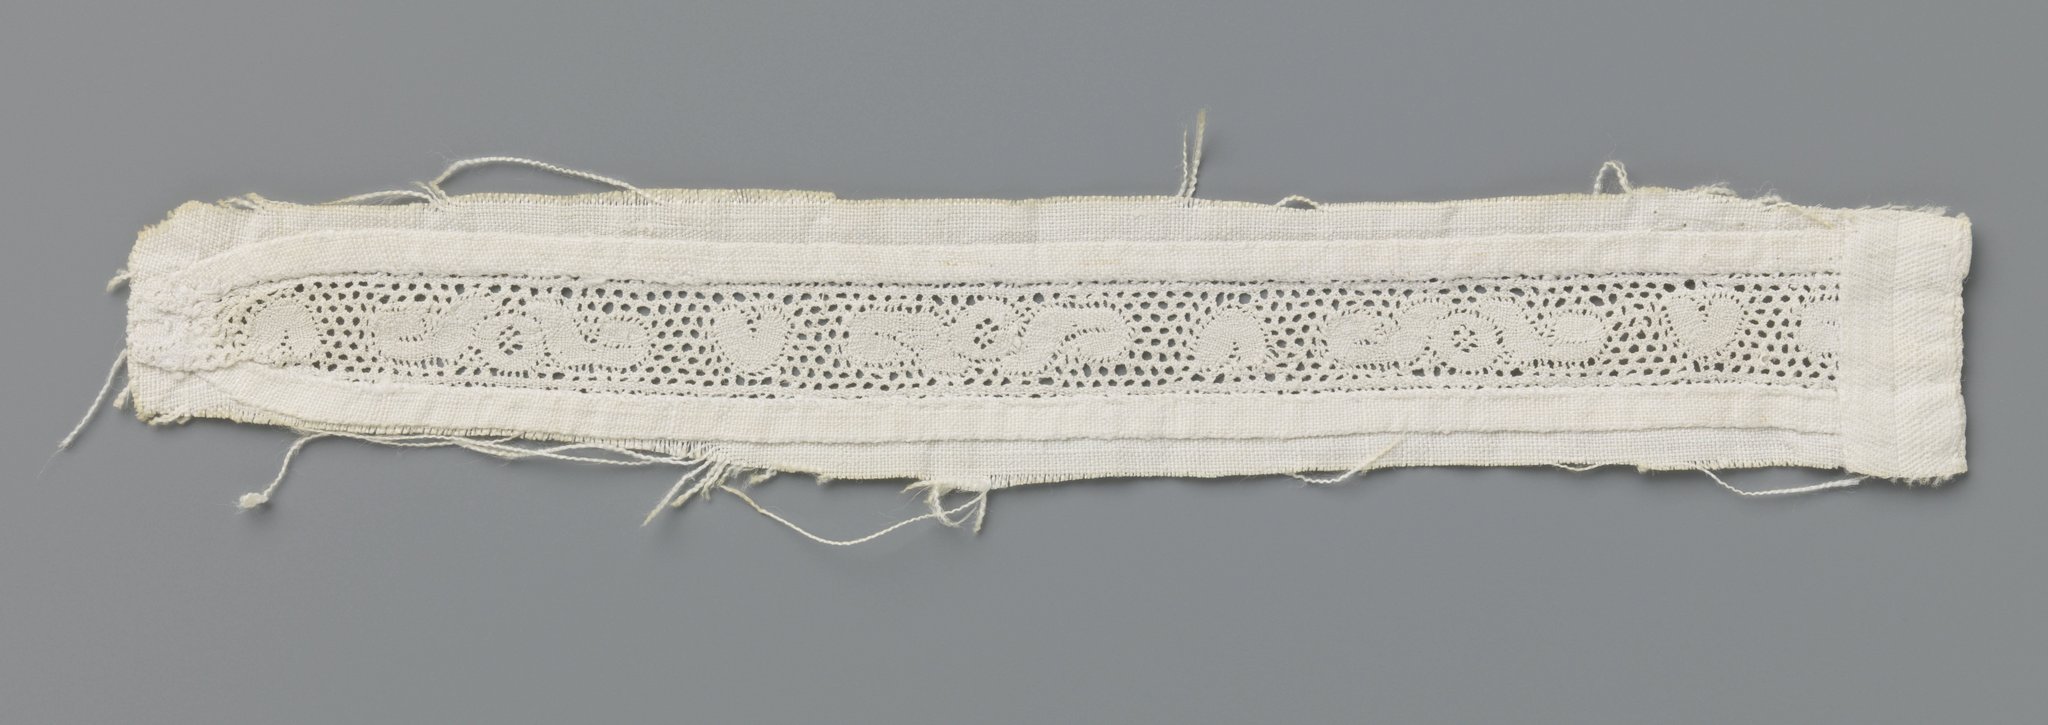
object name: strip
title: Tussenzetsel van kloskant met hartje en rond bloempje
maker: Anonymous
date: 1640-1660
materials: linen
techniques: lace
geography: antwerp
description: Tussenzetsel van naturelkleurige Hollandse kloskant. Het zich herhalende patroon bestaat afwisselend uit een hartje en een rond bloempje tussen twee langgerekte omkrullende bladeren. Het hartje staat afwisselend rechtop en omgekeerd. De motieven zijn met elkaar verbonden door een ronde traliegrond met vlechtslagen. De motieven zijn gemaakt in linnenslag met opengewerkte randjes en uitsparingen in het cirkelvormige bloemhart. Boven- en onderzijde van de strook zijn recht afgewerkt en vastgenaaid aan een fragment linnen afkomstig van een sloop.